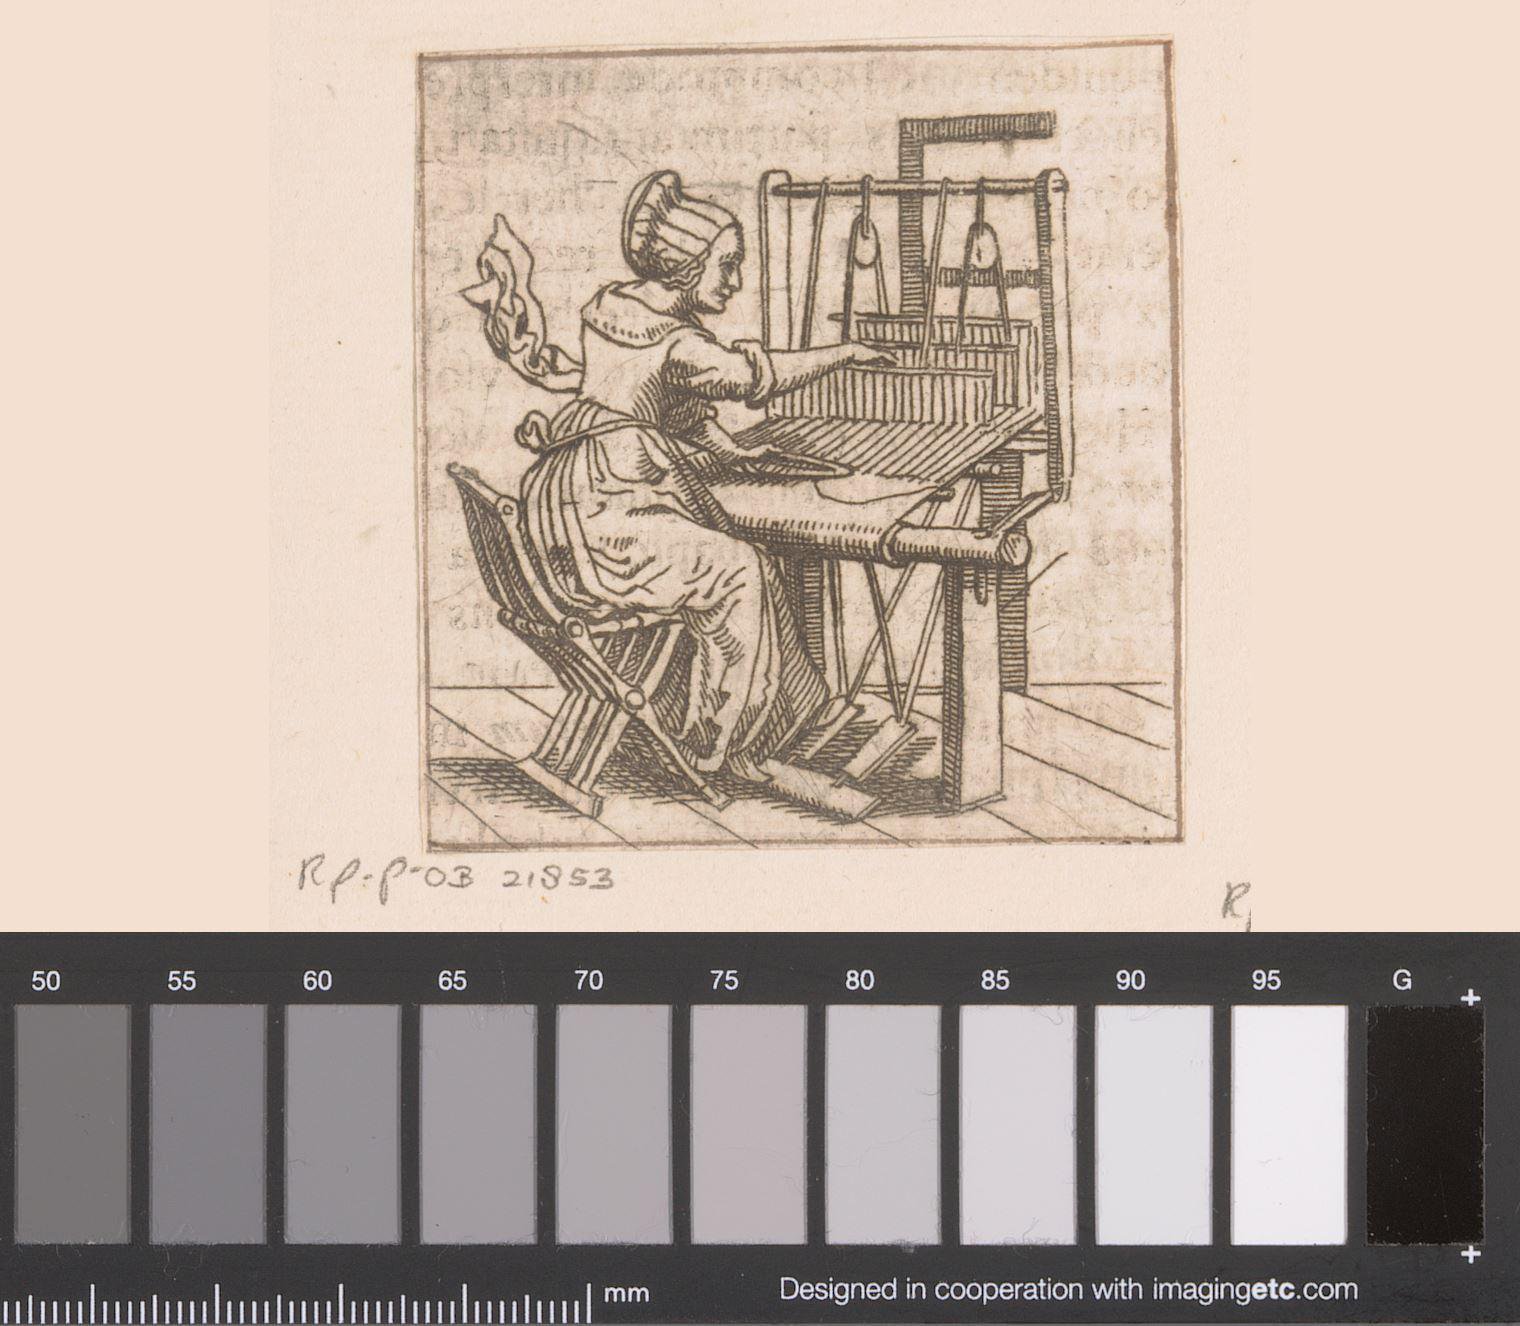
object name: print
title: Penelope weeft het lijkkleed van Laërtes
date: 1516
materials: paper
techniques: etching, letterpress printing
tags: rotterdam, desiderius erasmus, penelope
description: Prent afkomstig uit: Erasmus, Desiderius. Morias enkomion (...). Bazel: Johann Rudolf Genath, 1676. De prenten hierin zijn naar tekeningen die Hans en Ambrosius Holbein maakten voor de theoloog Oswald Myconius in diens uitgave van de Moriae encomium (Lof der Zotheid) van 1516.